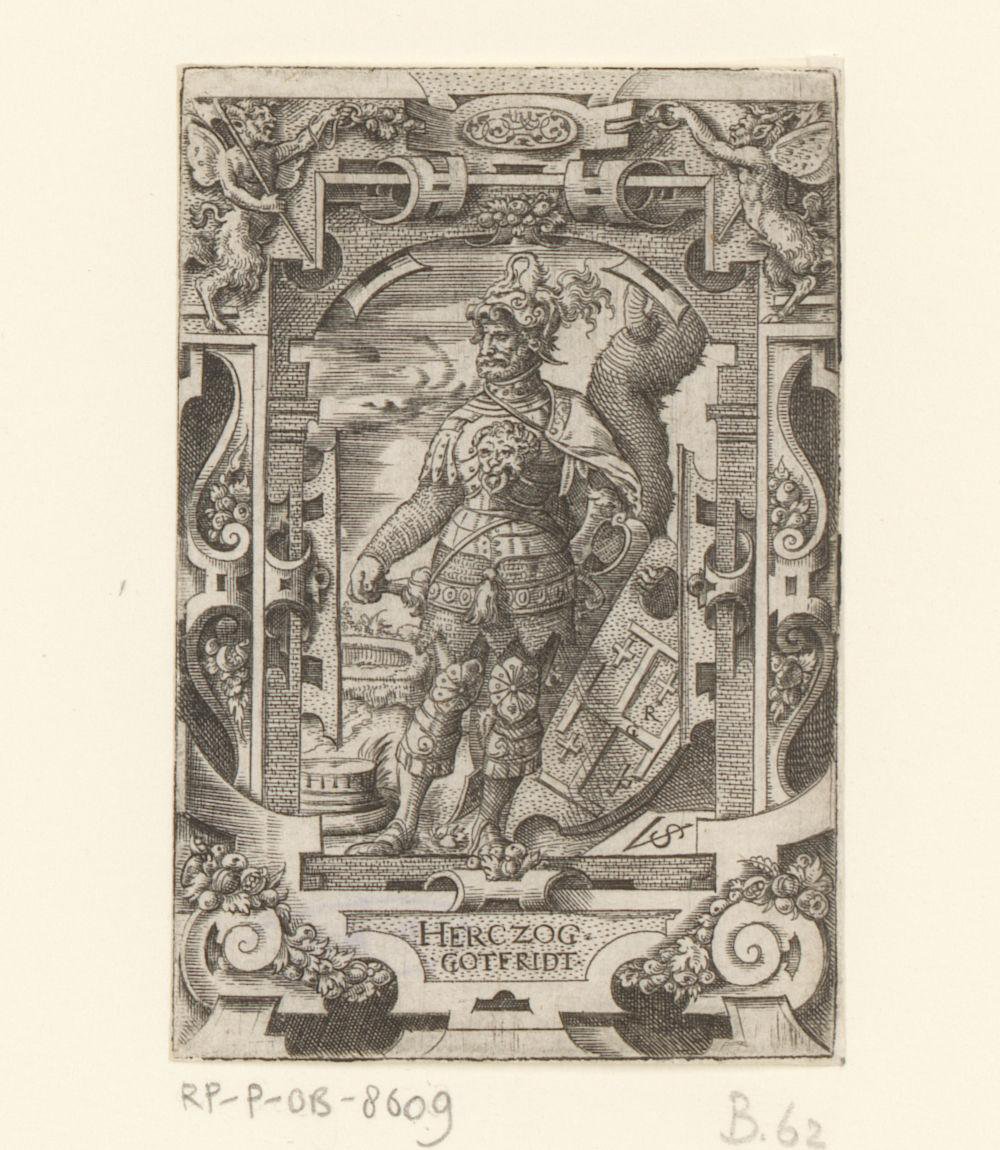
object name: print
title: Negen Besten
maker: virgilius solis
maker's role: draughtsman, print maker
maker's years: 1514-1562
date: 1524-1562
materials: paper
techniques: engraving, etching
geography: nuremberg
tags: godfrey of bouillon, godefroy of bouillon (one of the nine worthies)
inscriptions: collector's mark: Lugt 2228, number: ‘124’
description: Deze prent maakt deel uit van een serie bestaande uit negen prenten van de Negen Besten in rolwerk omlijstingen.